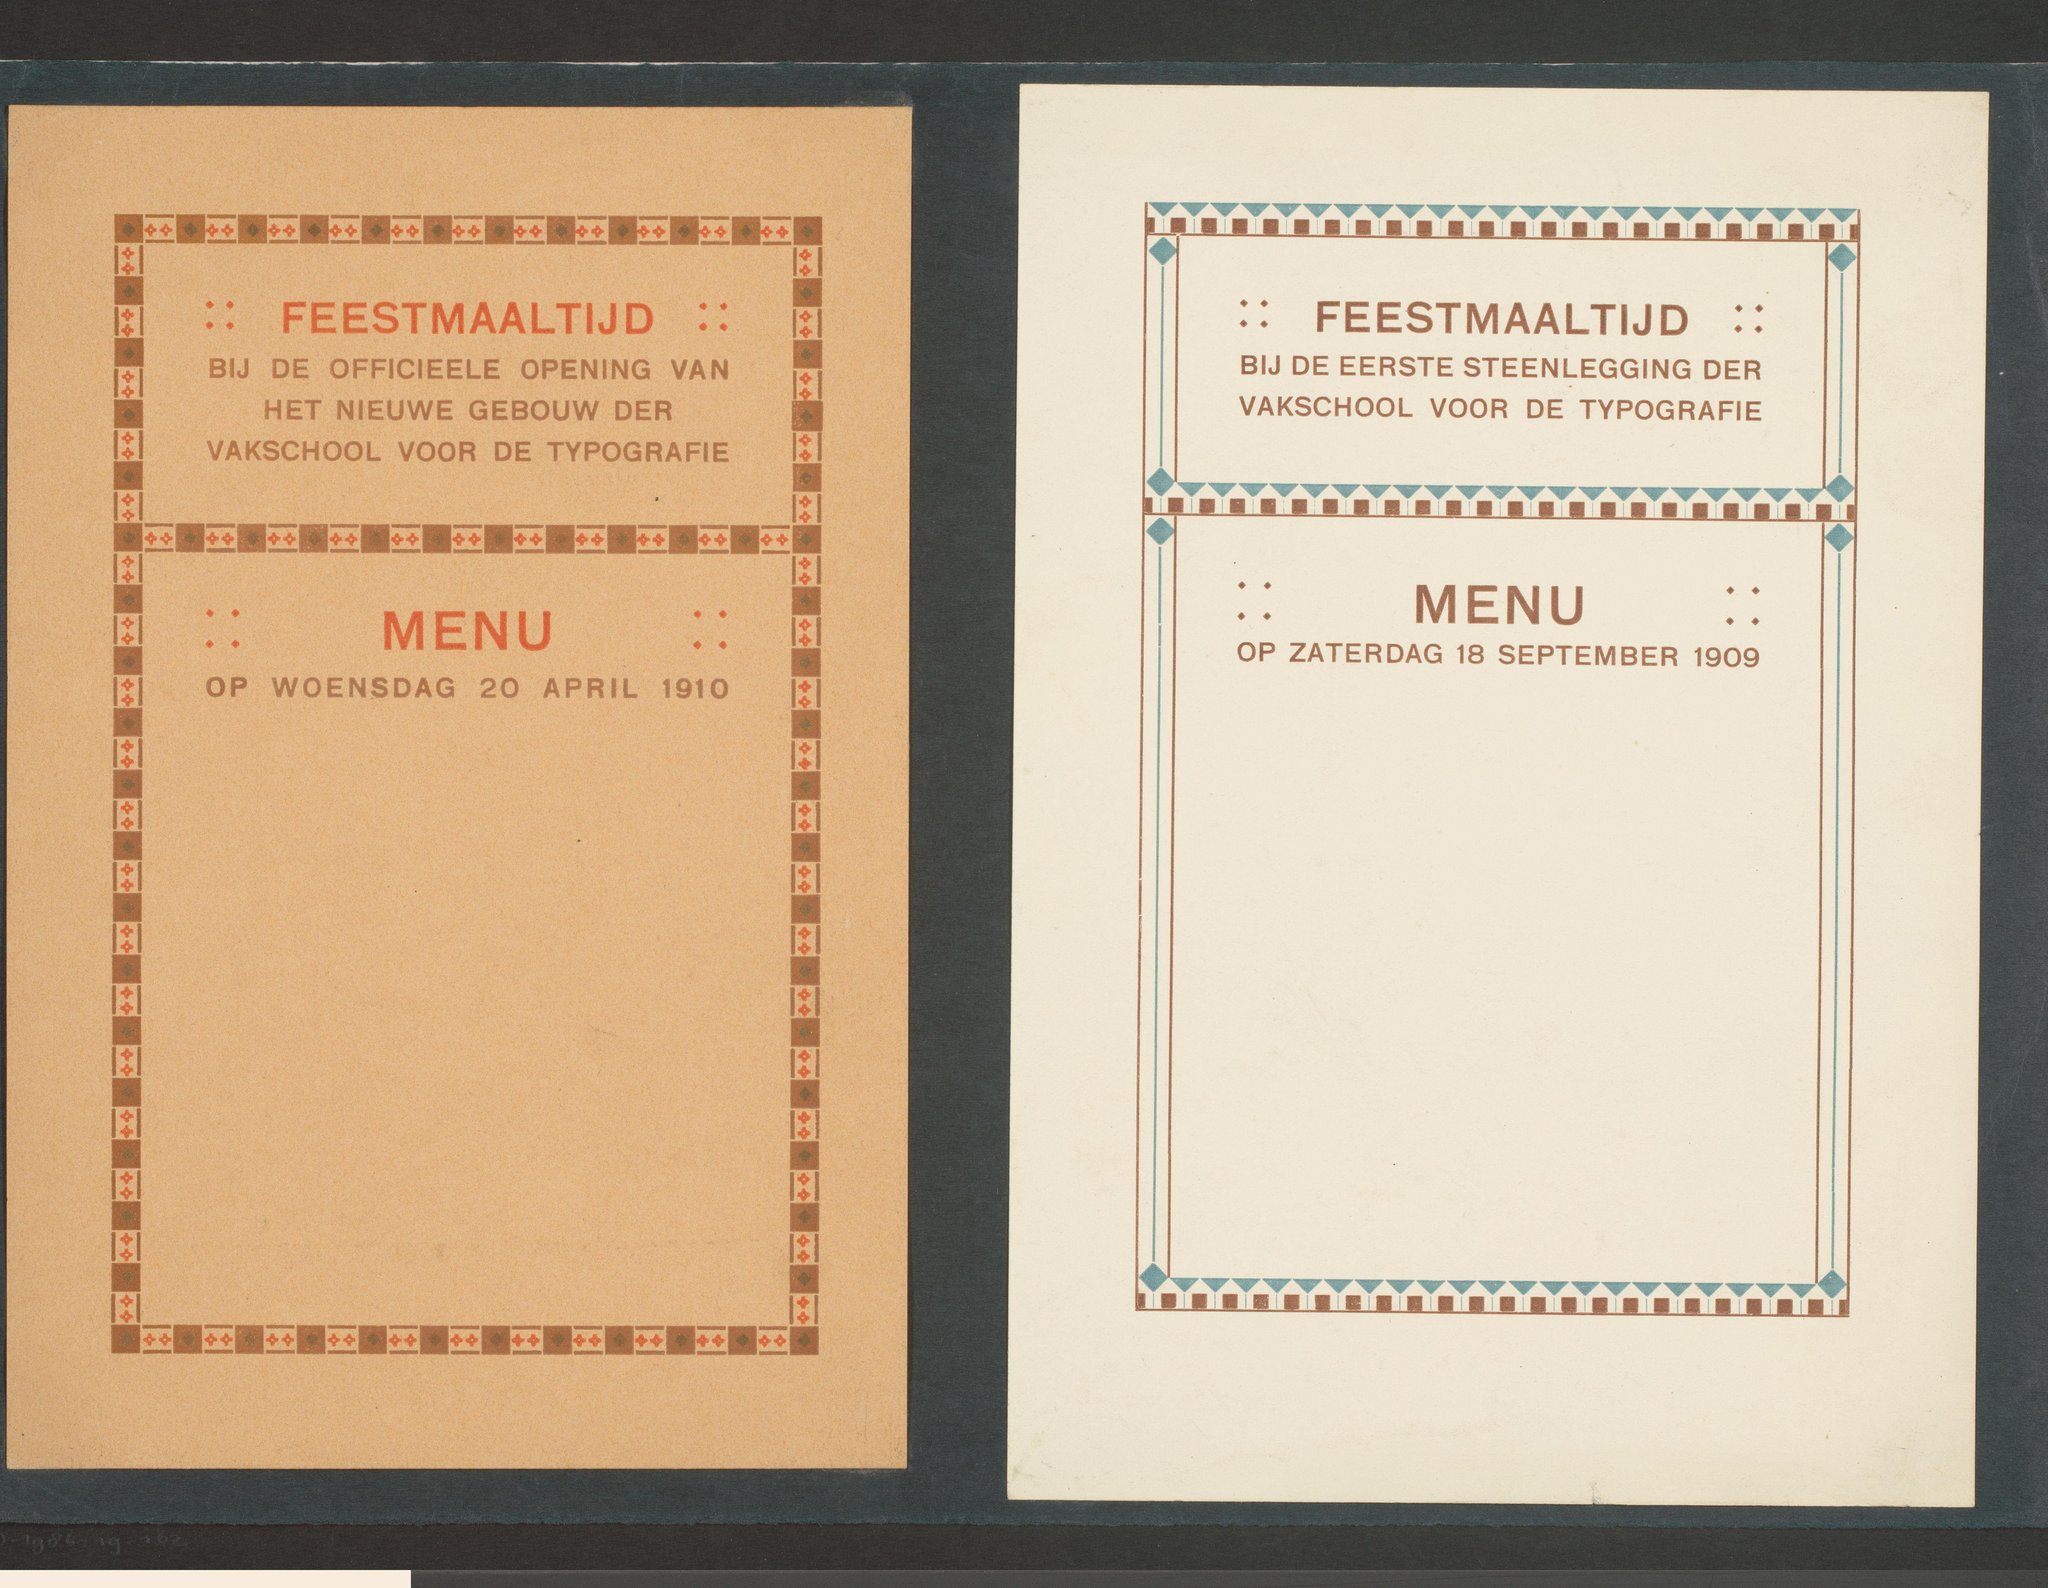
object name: photomechanical print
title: Menukaarten voor feestmaaltijden van de Vakschool voor de typografie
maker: reinier willem petrus de vries (1874-1953)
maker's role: draughtsman, print maker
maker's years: 1874-1953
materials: paper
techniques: printing block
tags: vakschool voor de typografie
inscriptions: date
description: De blanco menukaarten zijn ter gelegenheid van de eerstesteenlegging voor het nieuwe gebouw van de Vakschool voor de typografie en voor de officiële opening enkele maanden later.